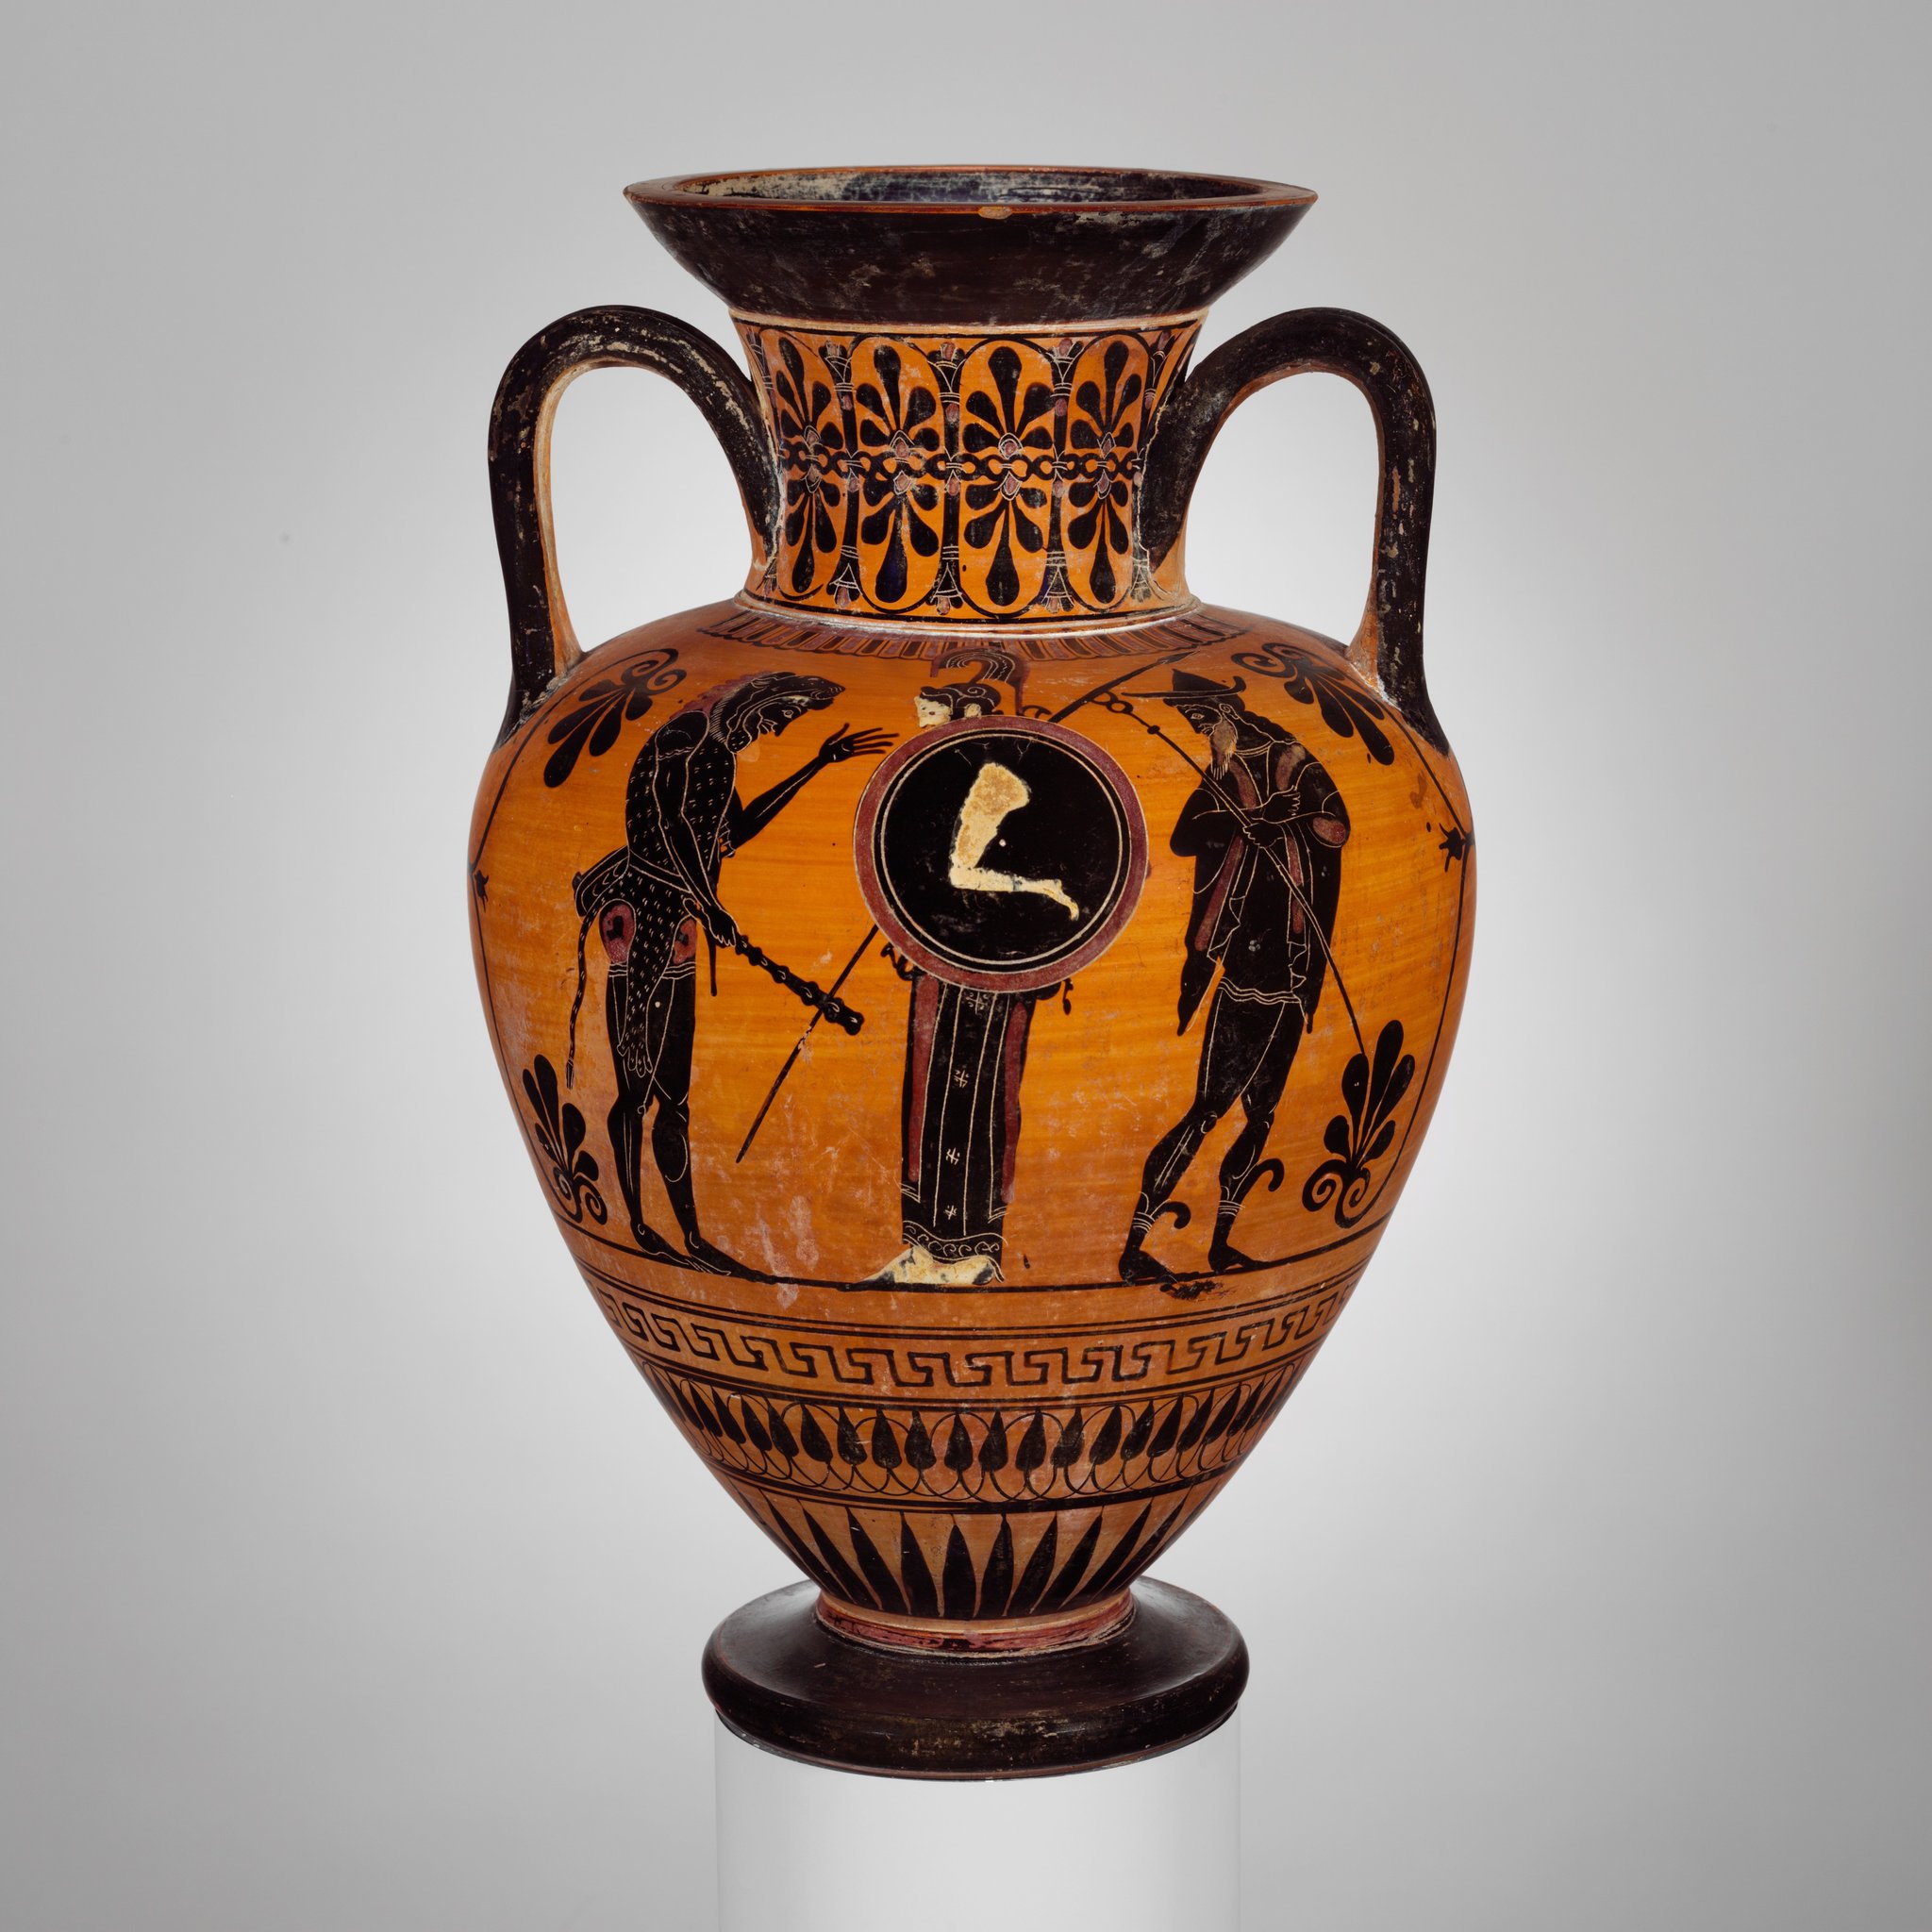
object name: neck amphora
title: Terracotta neck-amphora (jar)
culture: greek, attic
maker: antimenes painter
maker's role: artist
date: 520 BCE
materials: terracotta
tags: shields,athena,hermes,chariots